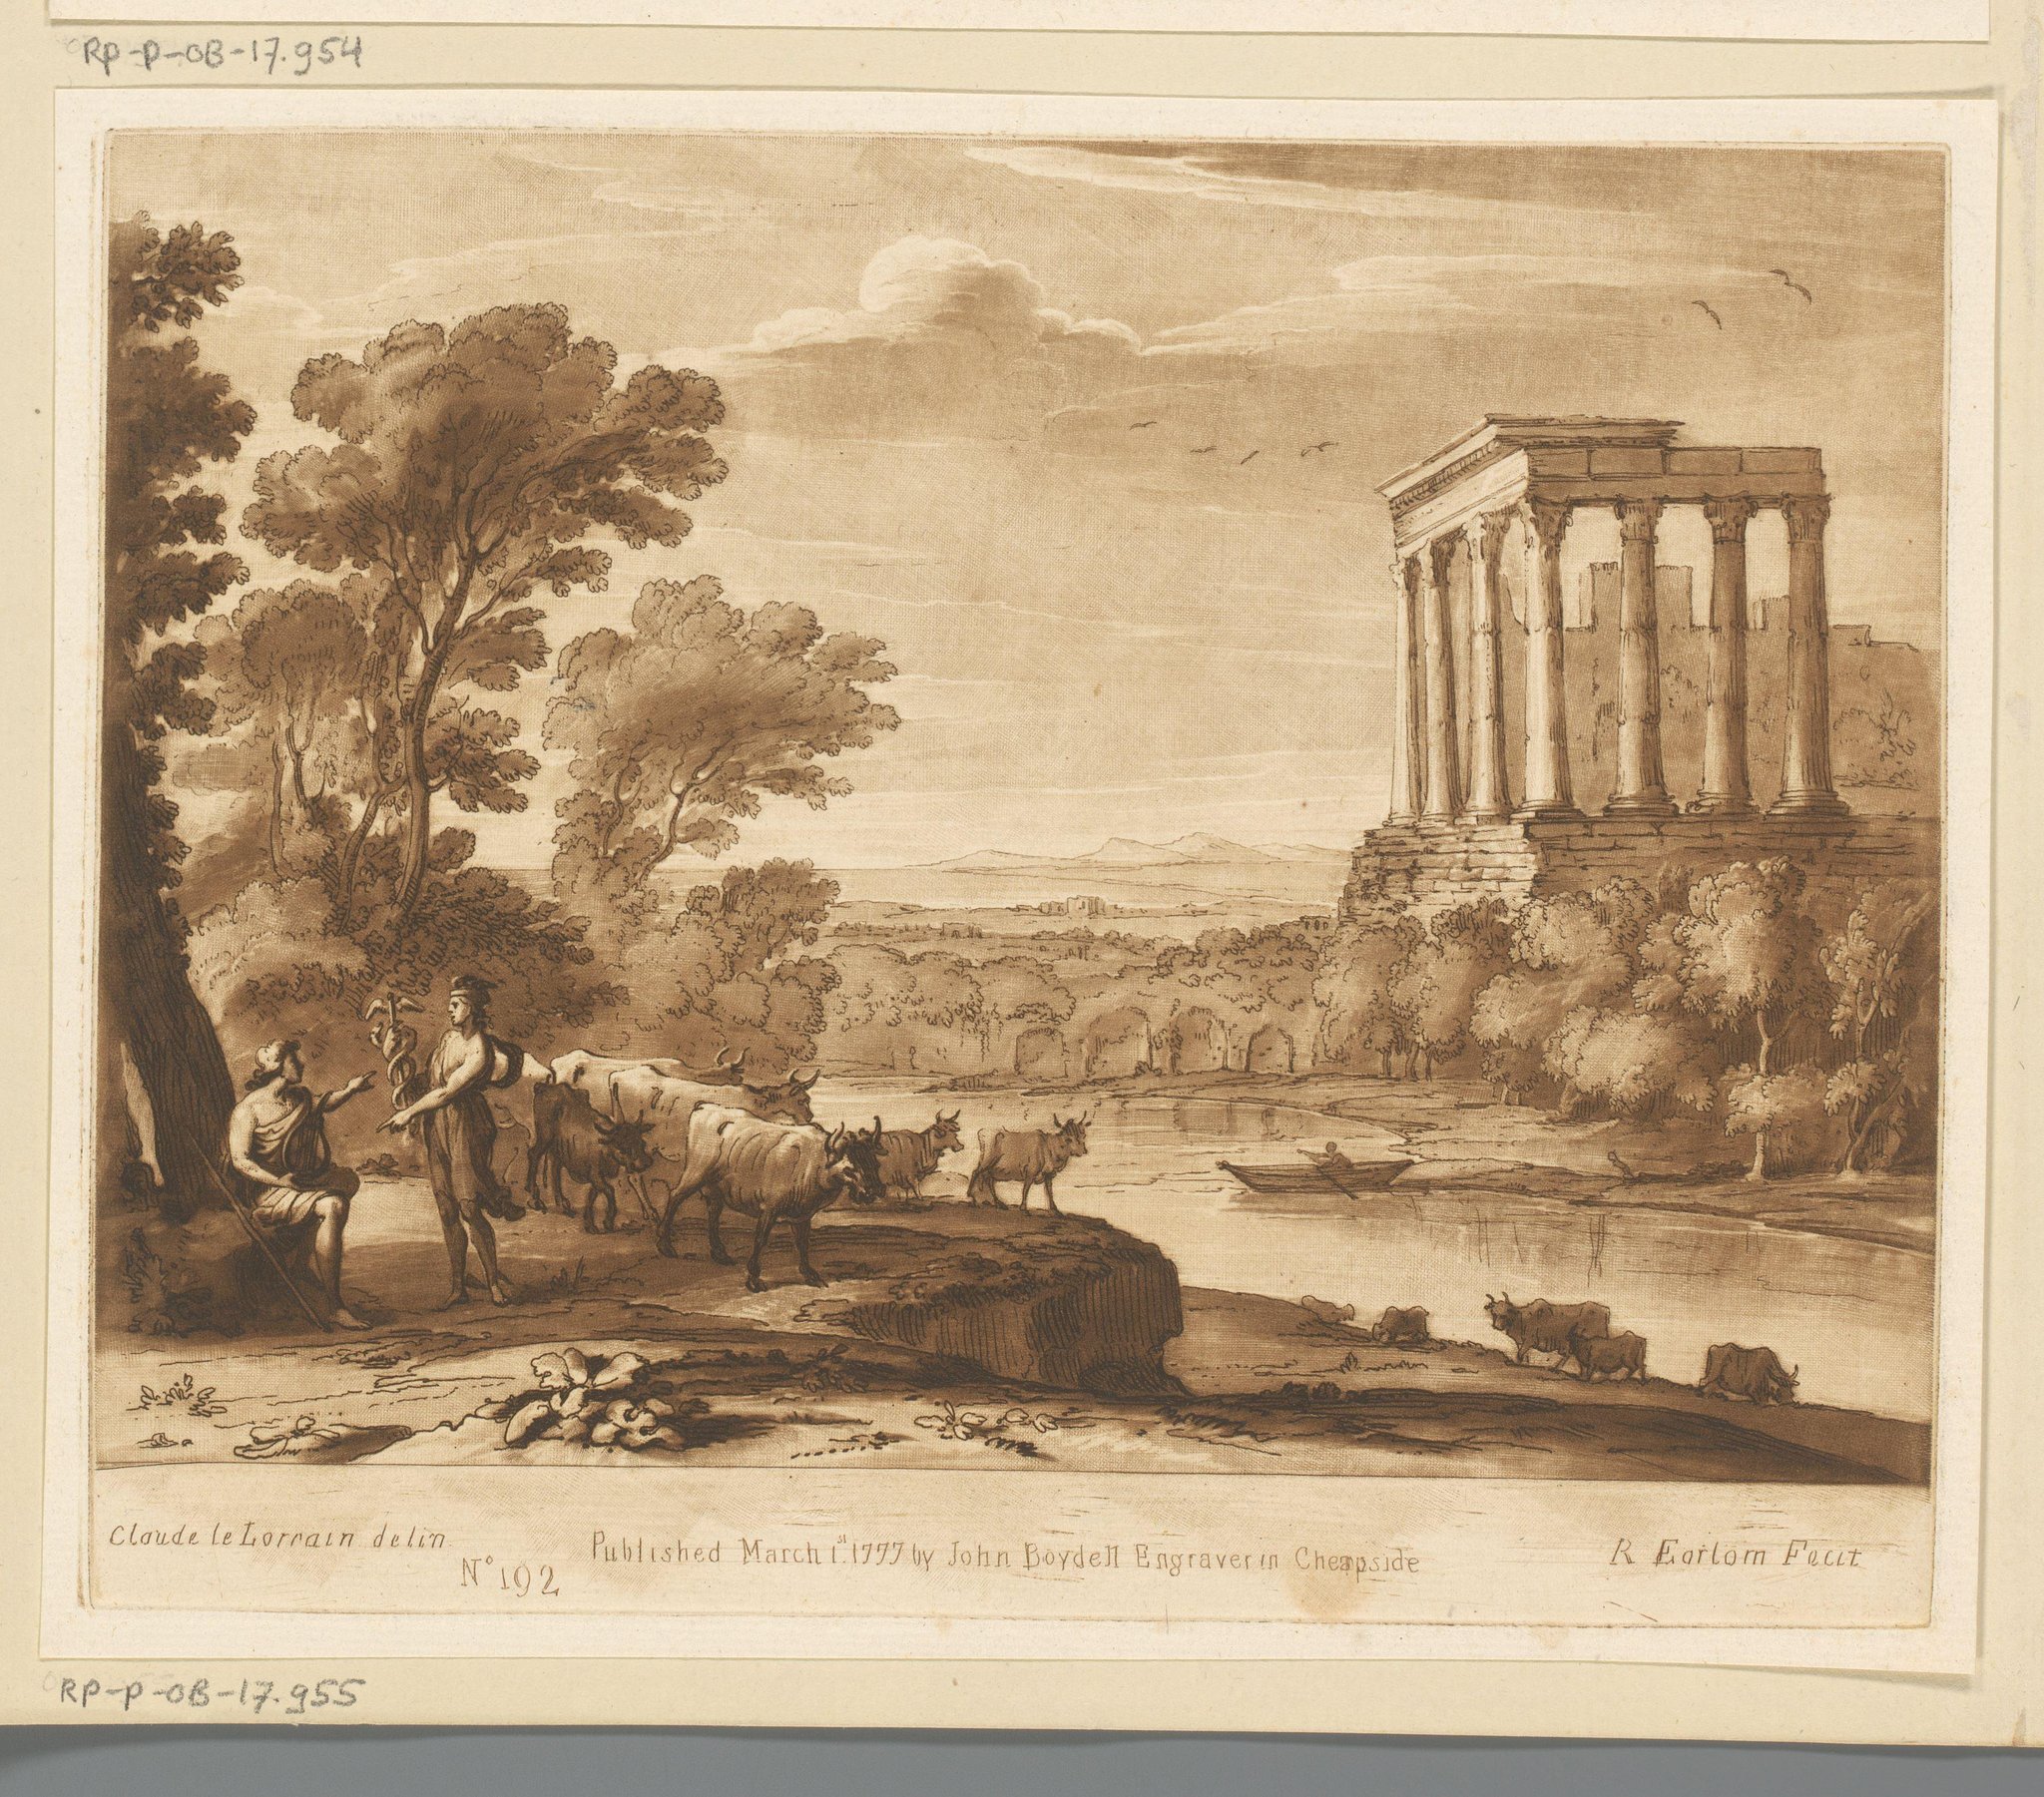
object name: print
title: Landschap met Mercurius die de lier aan Apollo geeft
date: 1777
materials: paper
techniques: etching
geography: london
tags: river - hh - ideal landscapes, cattle, mercury gives his lyre to apollo, apollo gives his staff (caduceus) to mercury in return for the lyre, landscape with ruins - ii - ideal landscapes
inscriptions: date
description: Vanaf 1774 publiceerde John Boydell tweehonderd prenten naar het tekeningenboek Liber Veritatis van Claude Lorrain, in het bezit van de hertogen van Cavendish. Deze prenten werden vanaf 1777 in twee volumes gebundeld uitgegeven.